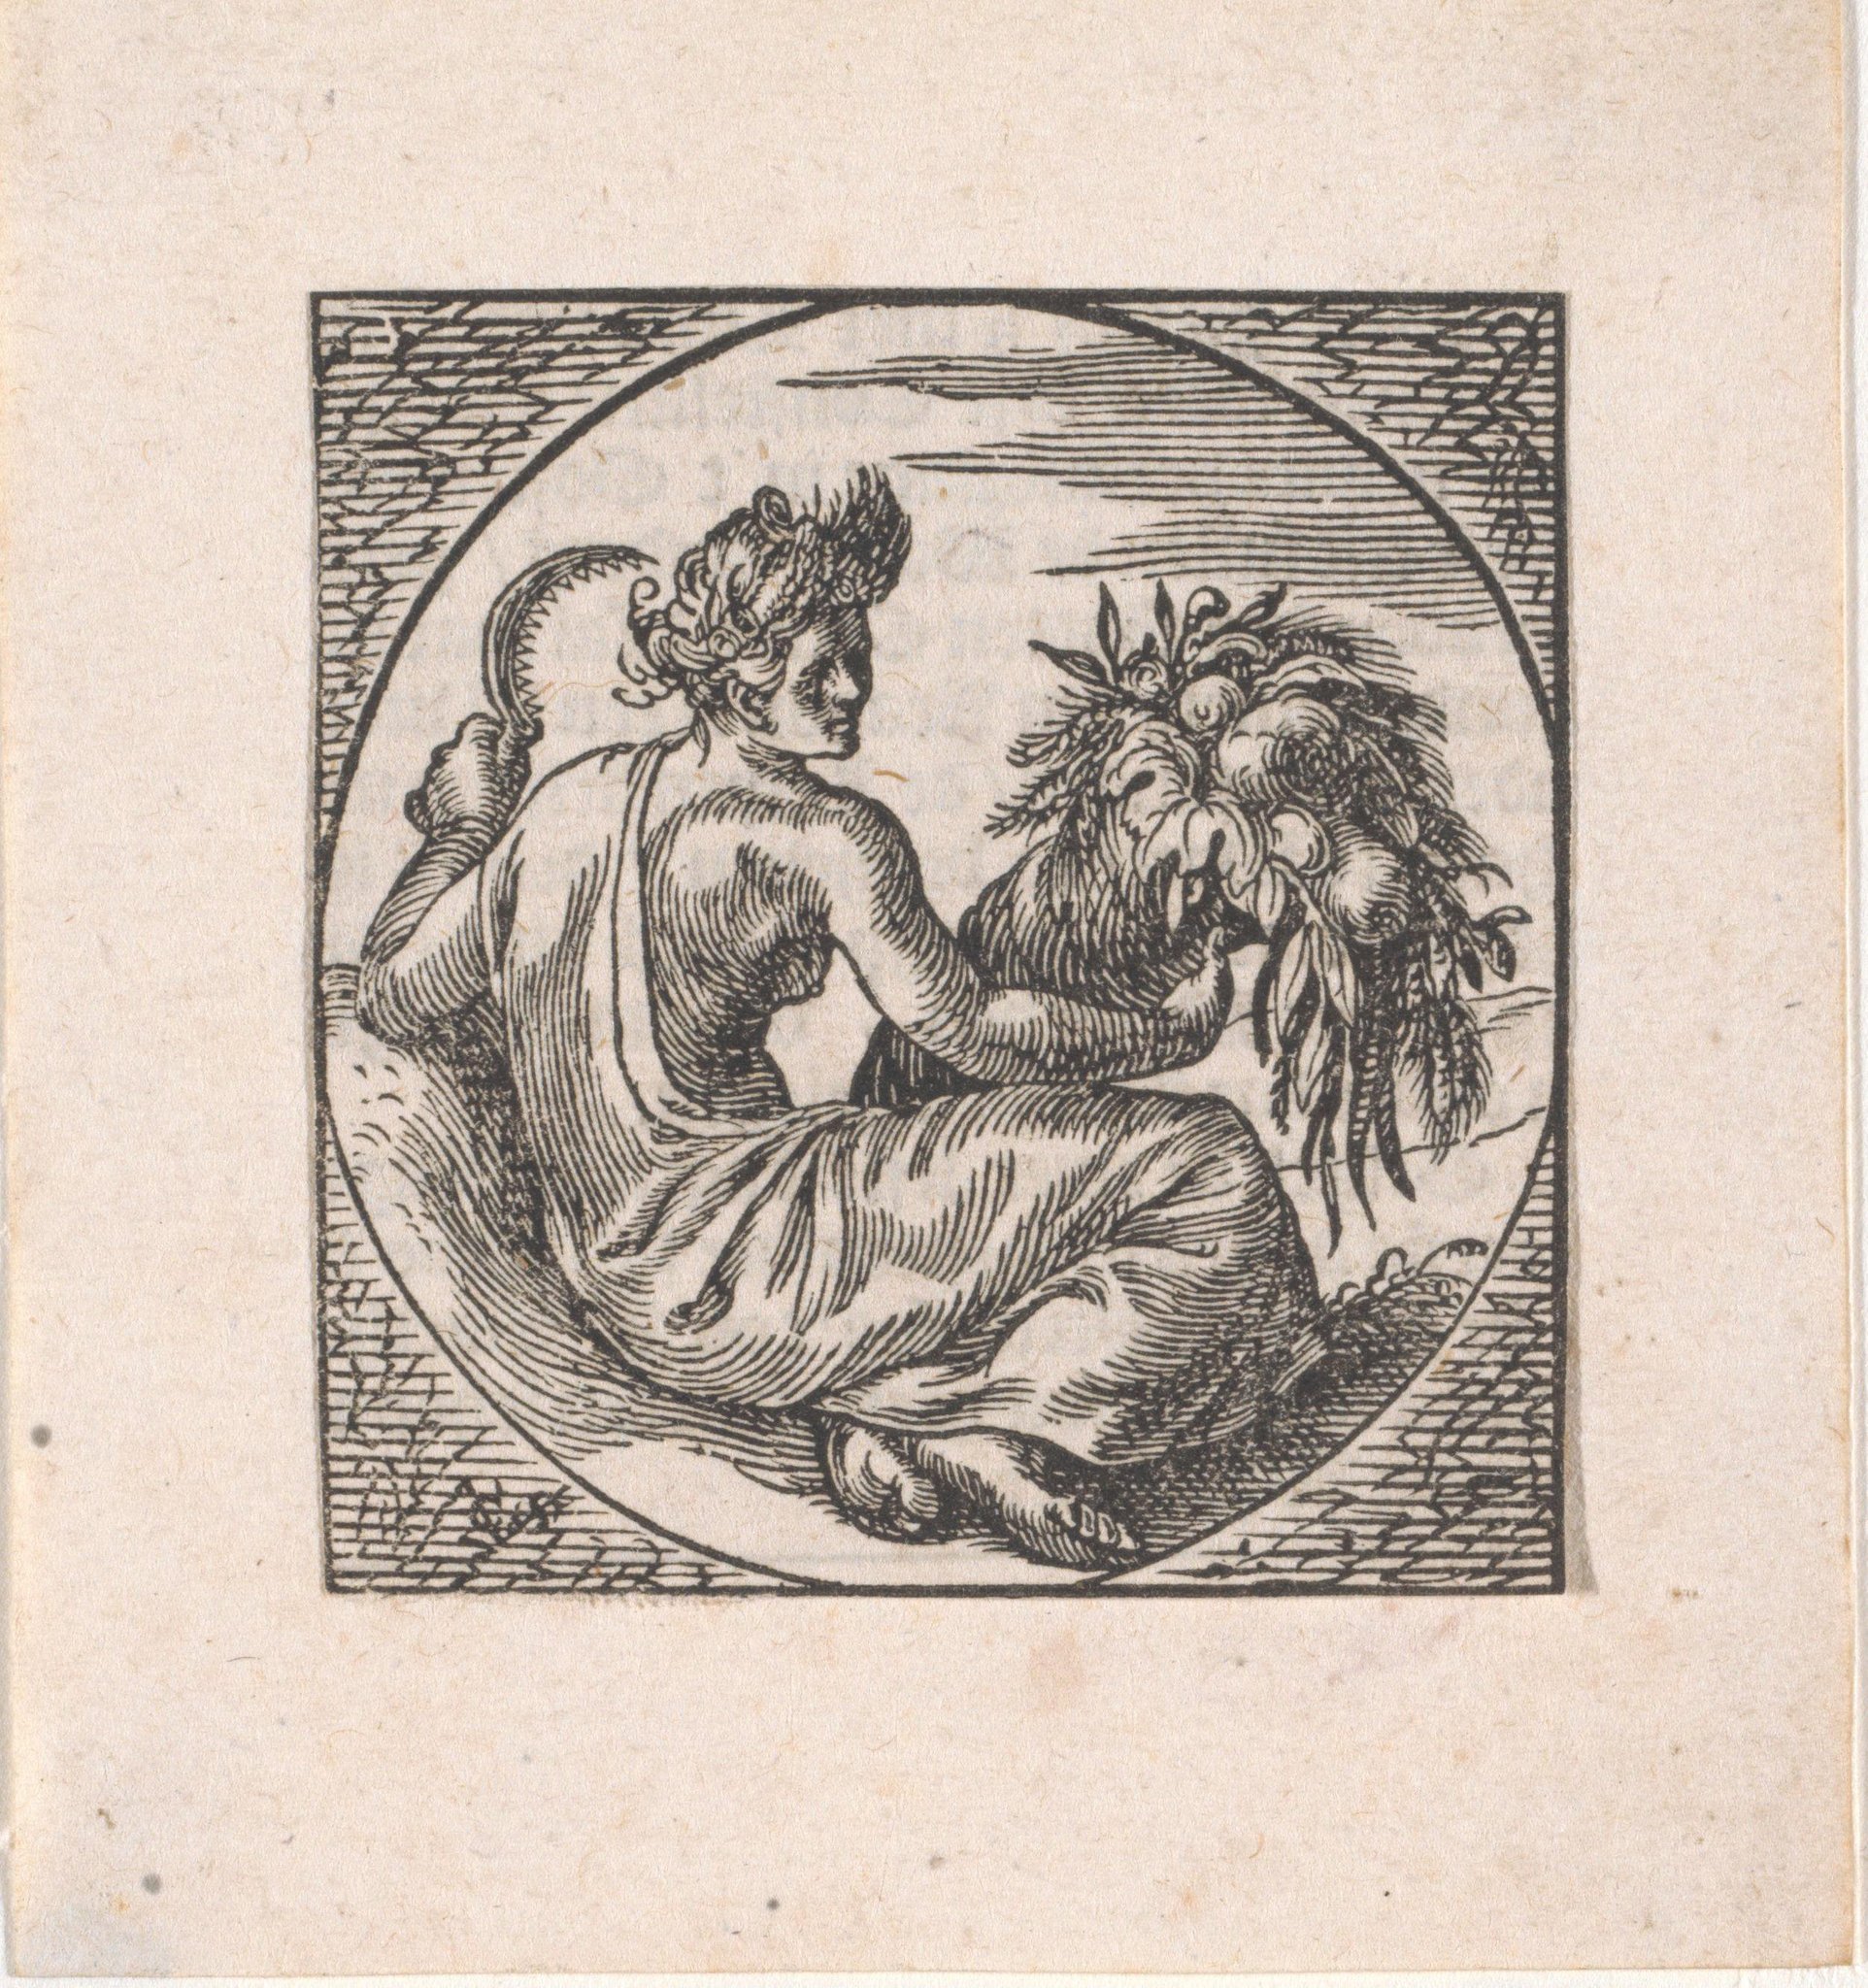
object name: print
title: Vier seizoenen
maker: christoffel van sichem (ii)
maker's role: print maker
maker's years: 1581-1658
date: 1581-1658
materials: paper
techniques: woodcut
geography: amsterdam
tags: 'cornucopia', horn of plenty, specific aspects, allegorical aspects of ceres; ceres as patroness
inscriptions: collector's mark: Lugt 240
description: Ceres met de hoorn des overvloeds in een cirkelvormige omlijsting.